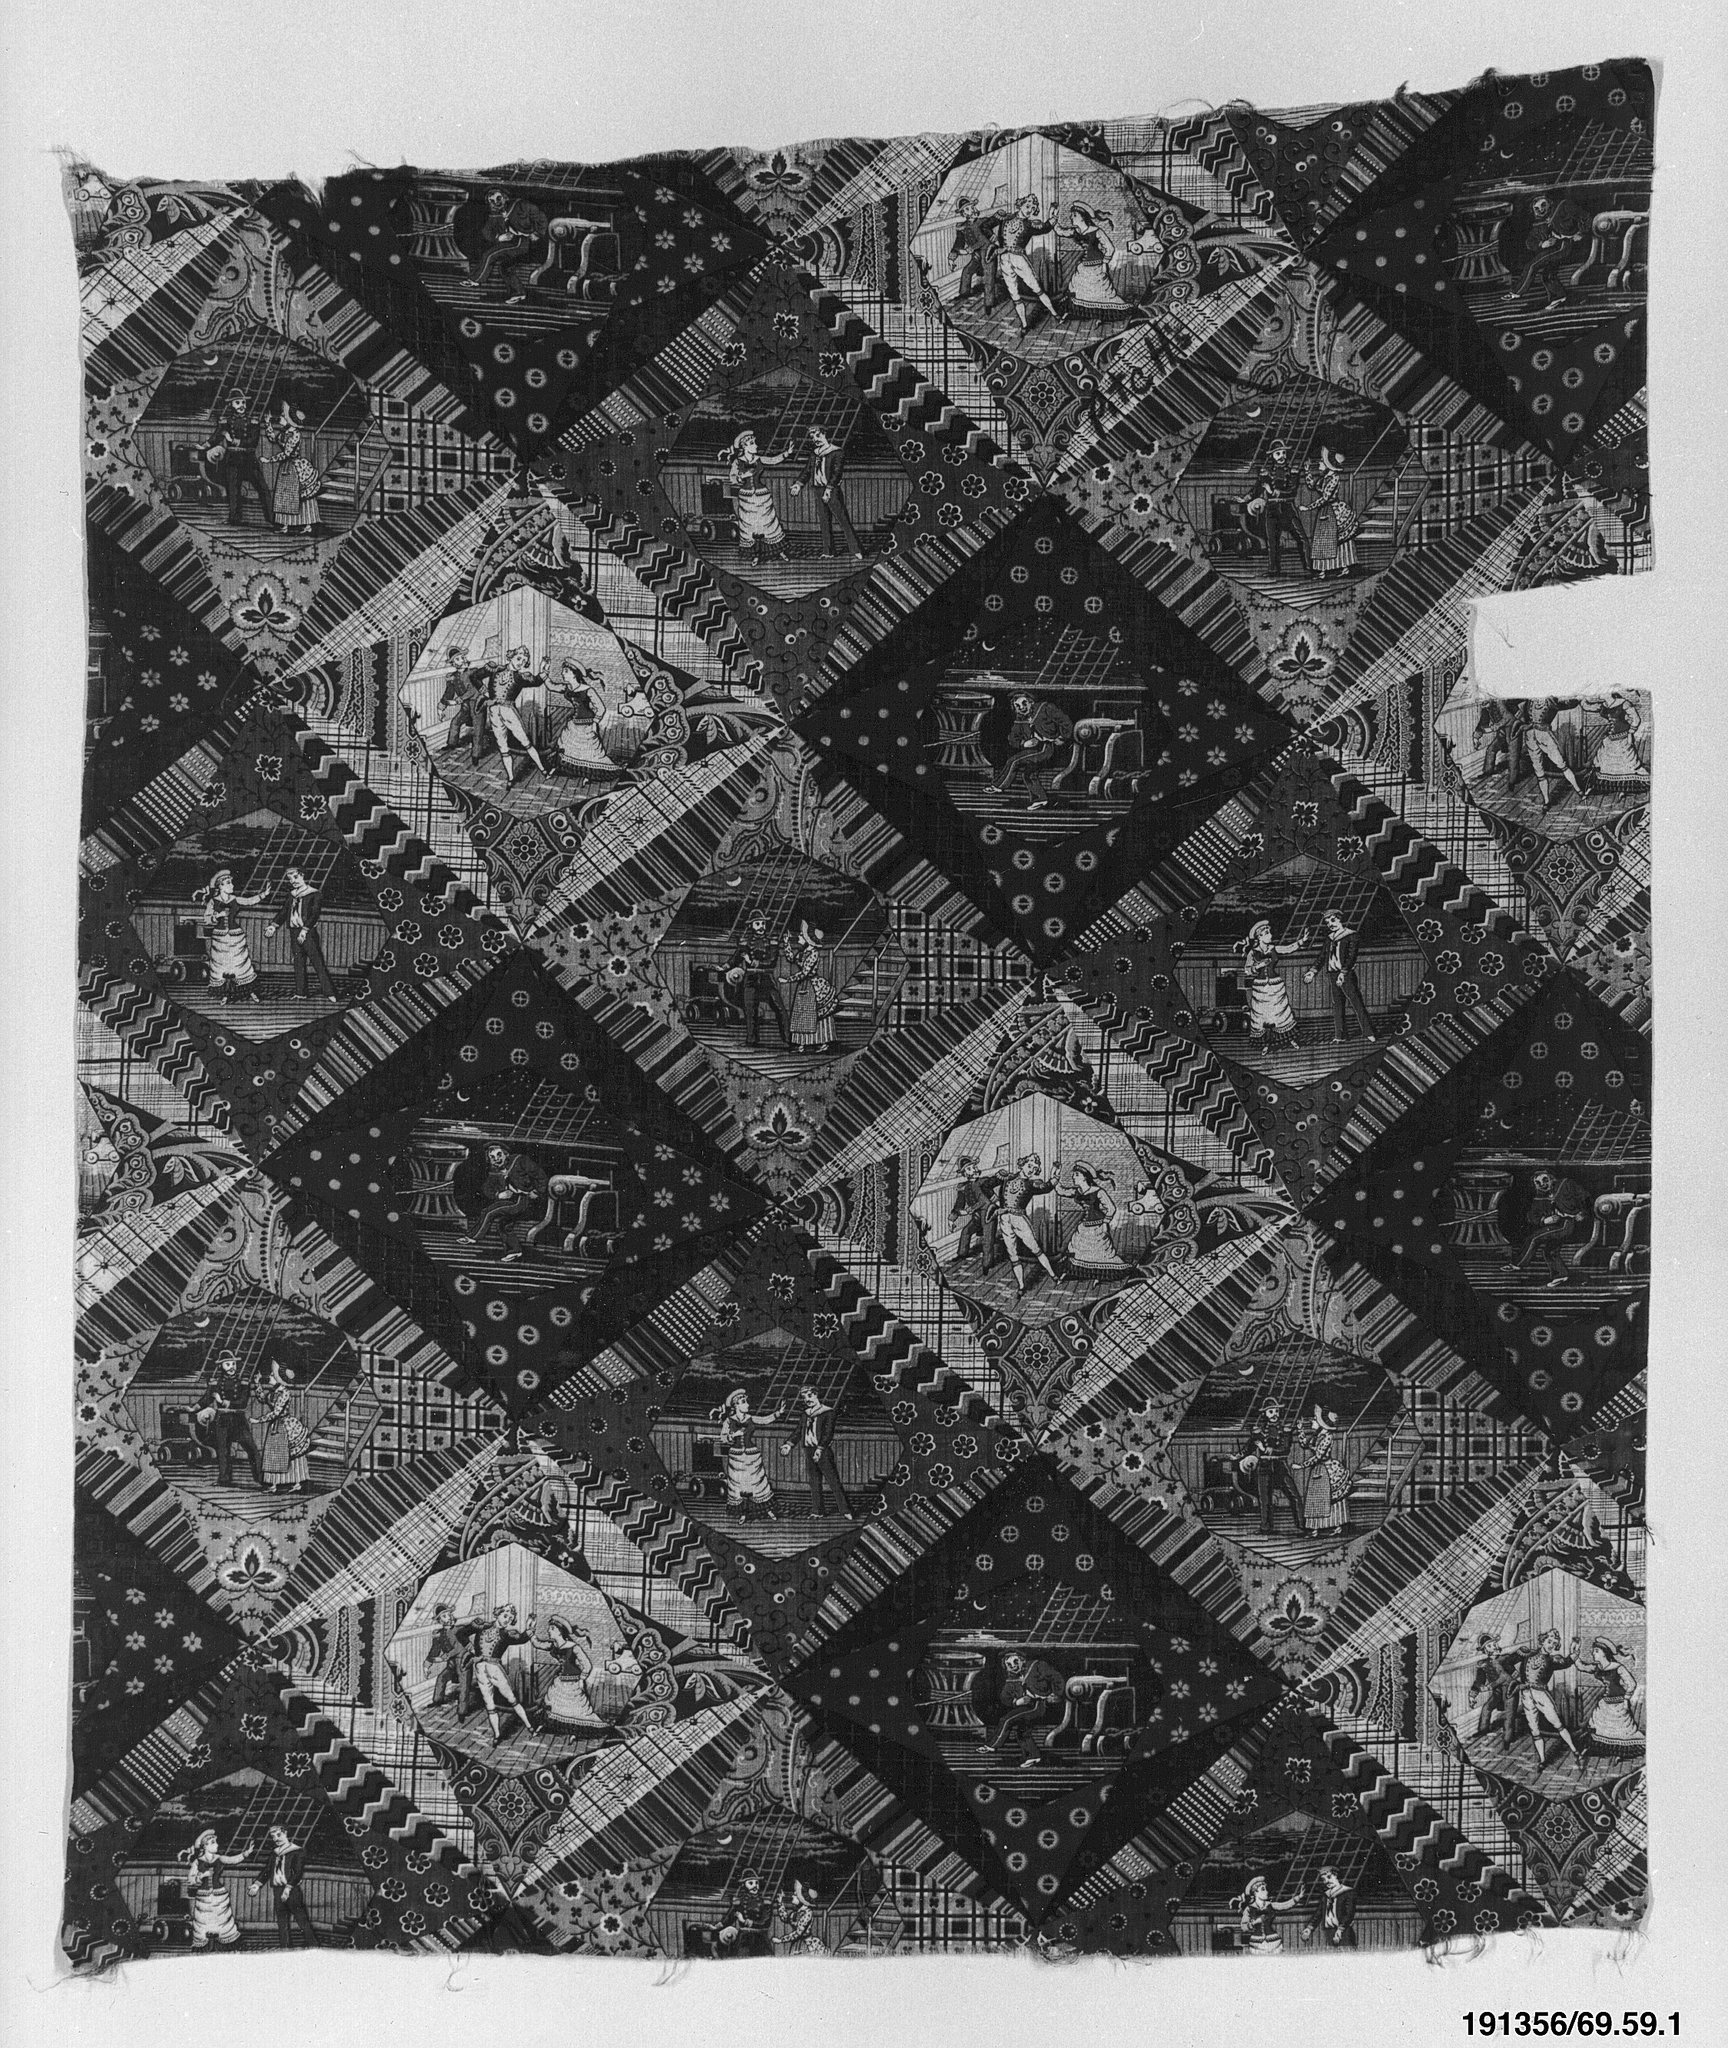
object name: length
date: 1867-1900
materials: cotton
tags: men,women,flowers